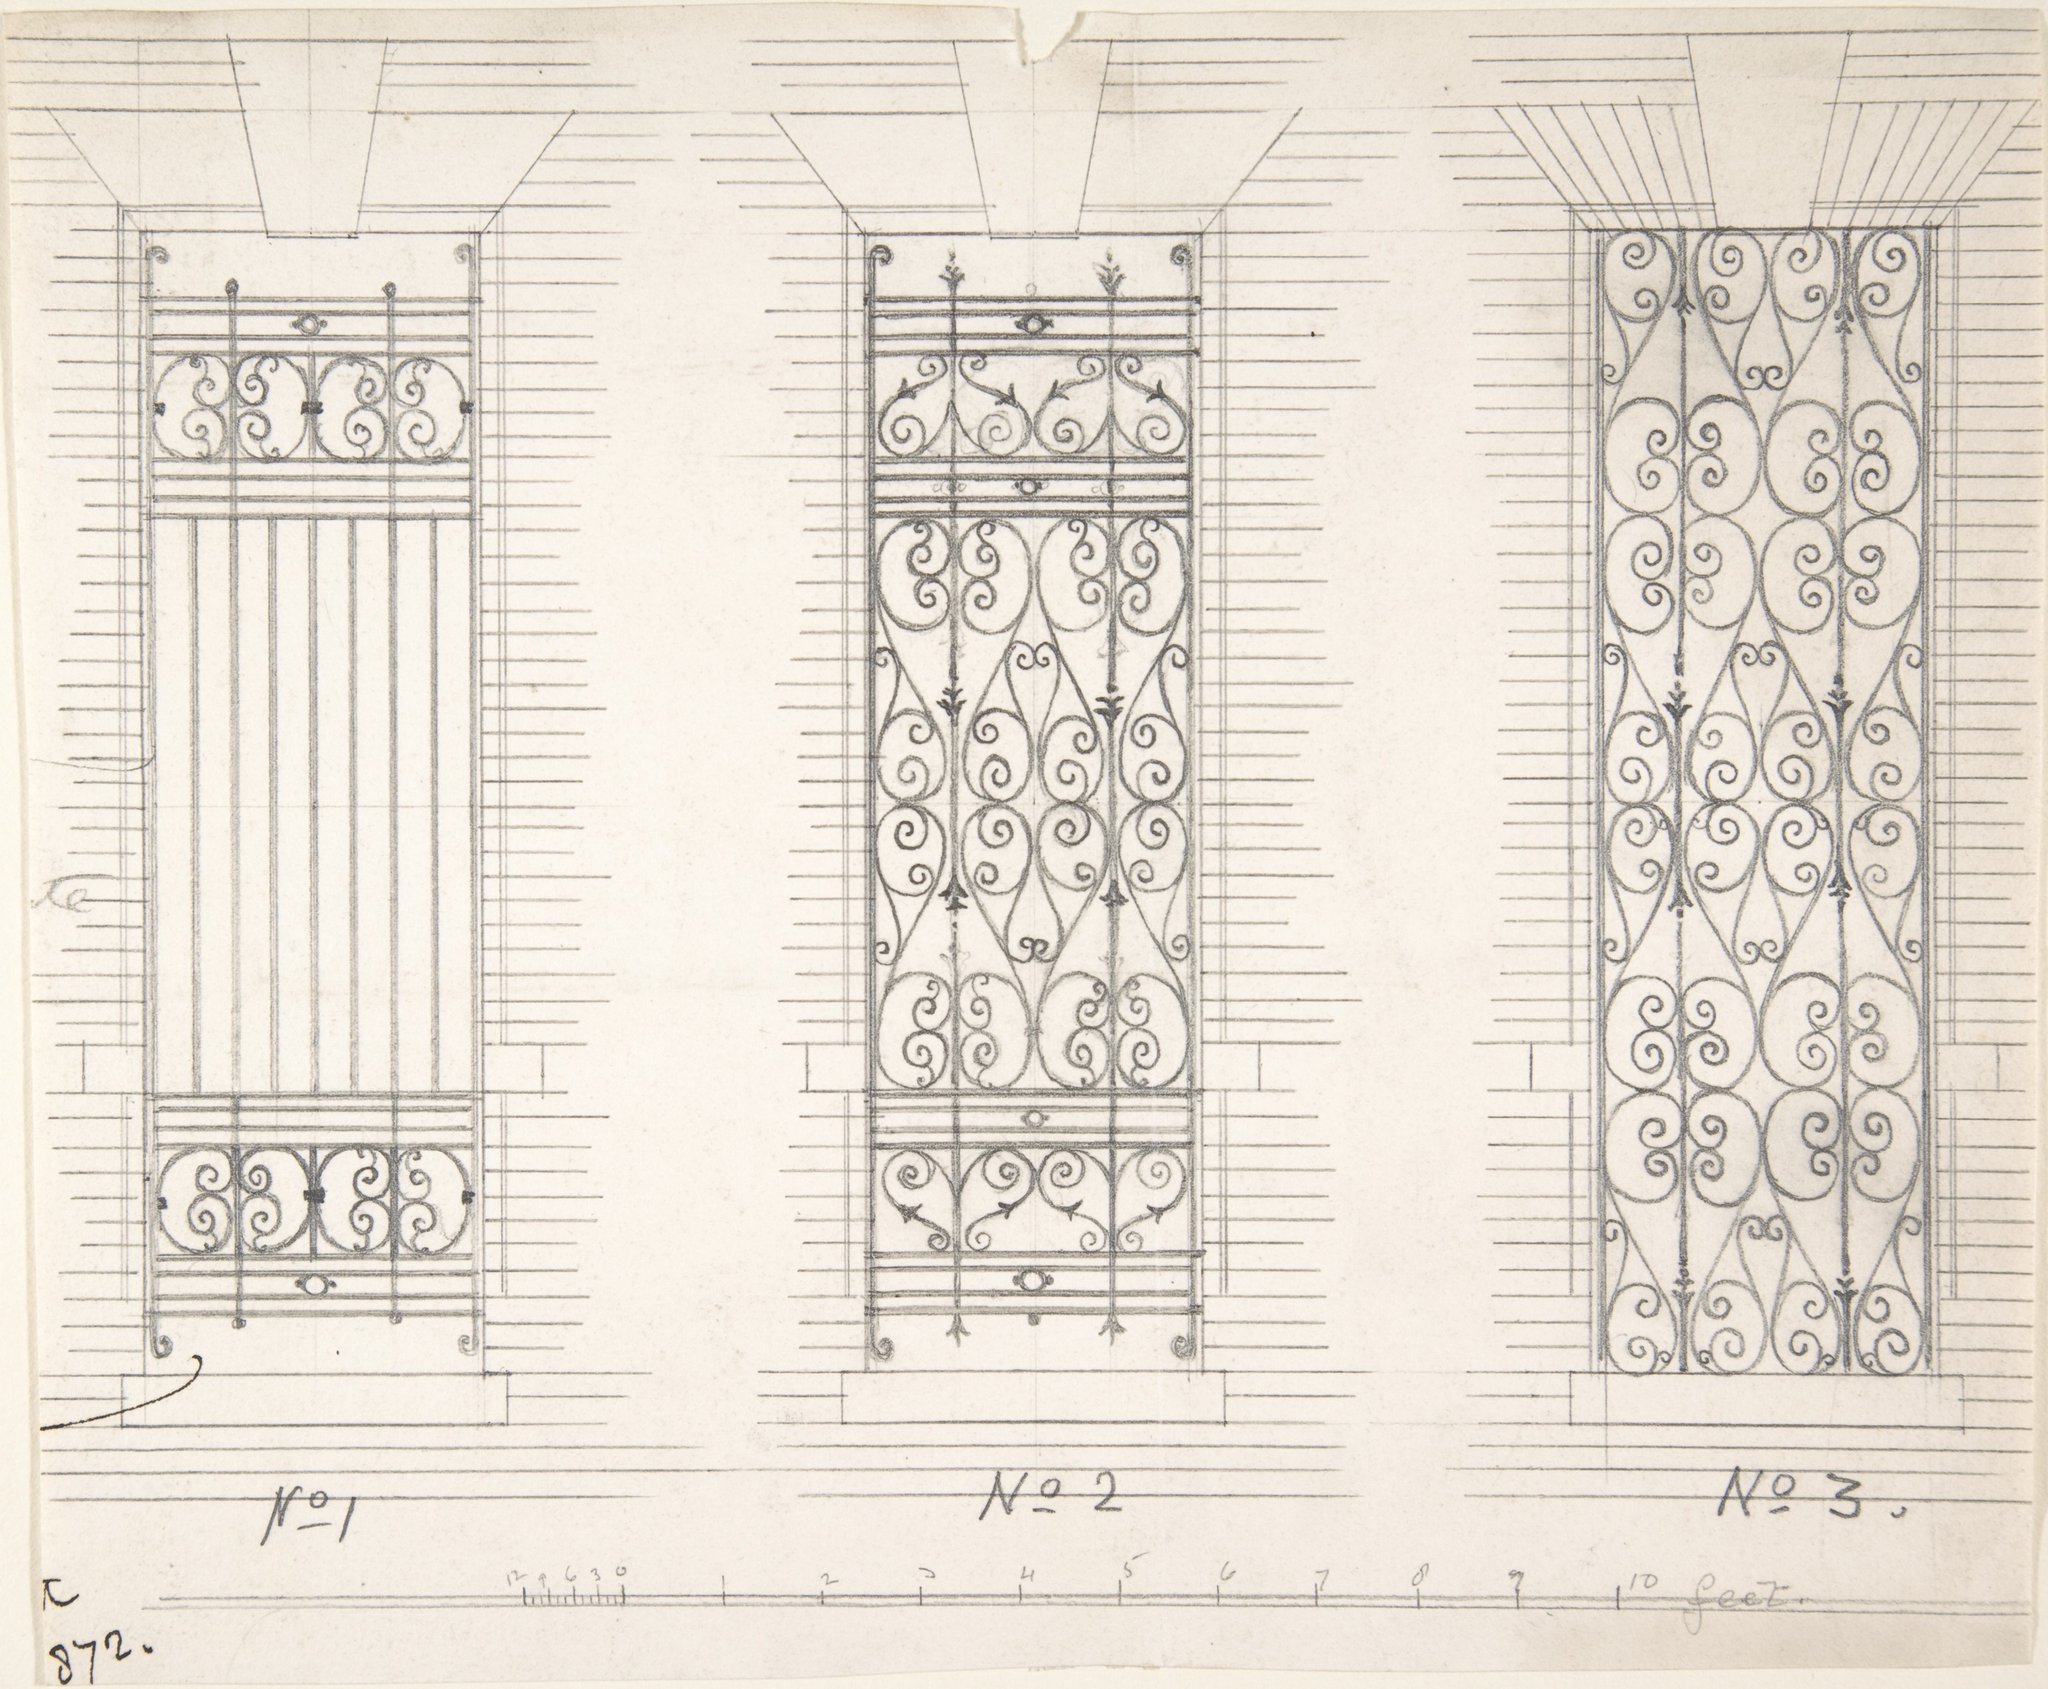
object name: drawing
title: Design for Three Wrought Iron Window Guards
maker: anonymous, british, 19th century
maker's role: artist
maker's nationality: british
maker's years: 1800-1900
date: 1851-1900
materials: graphite